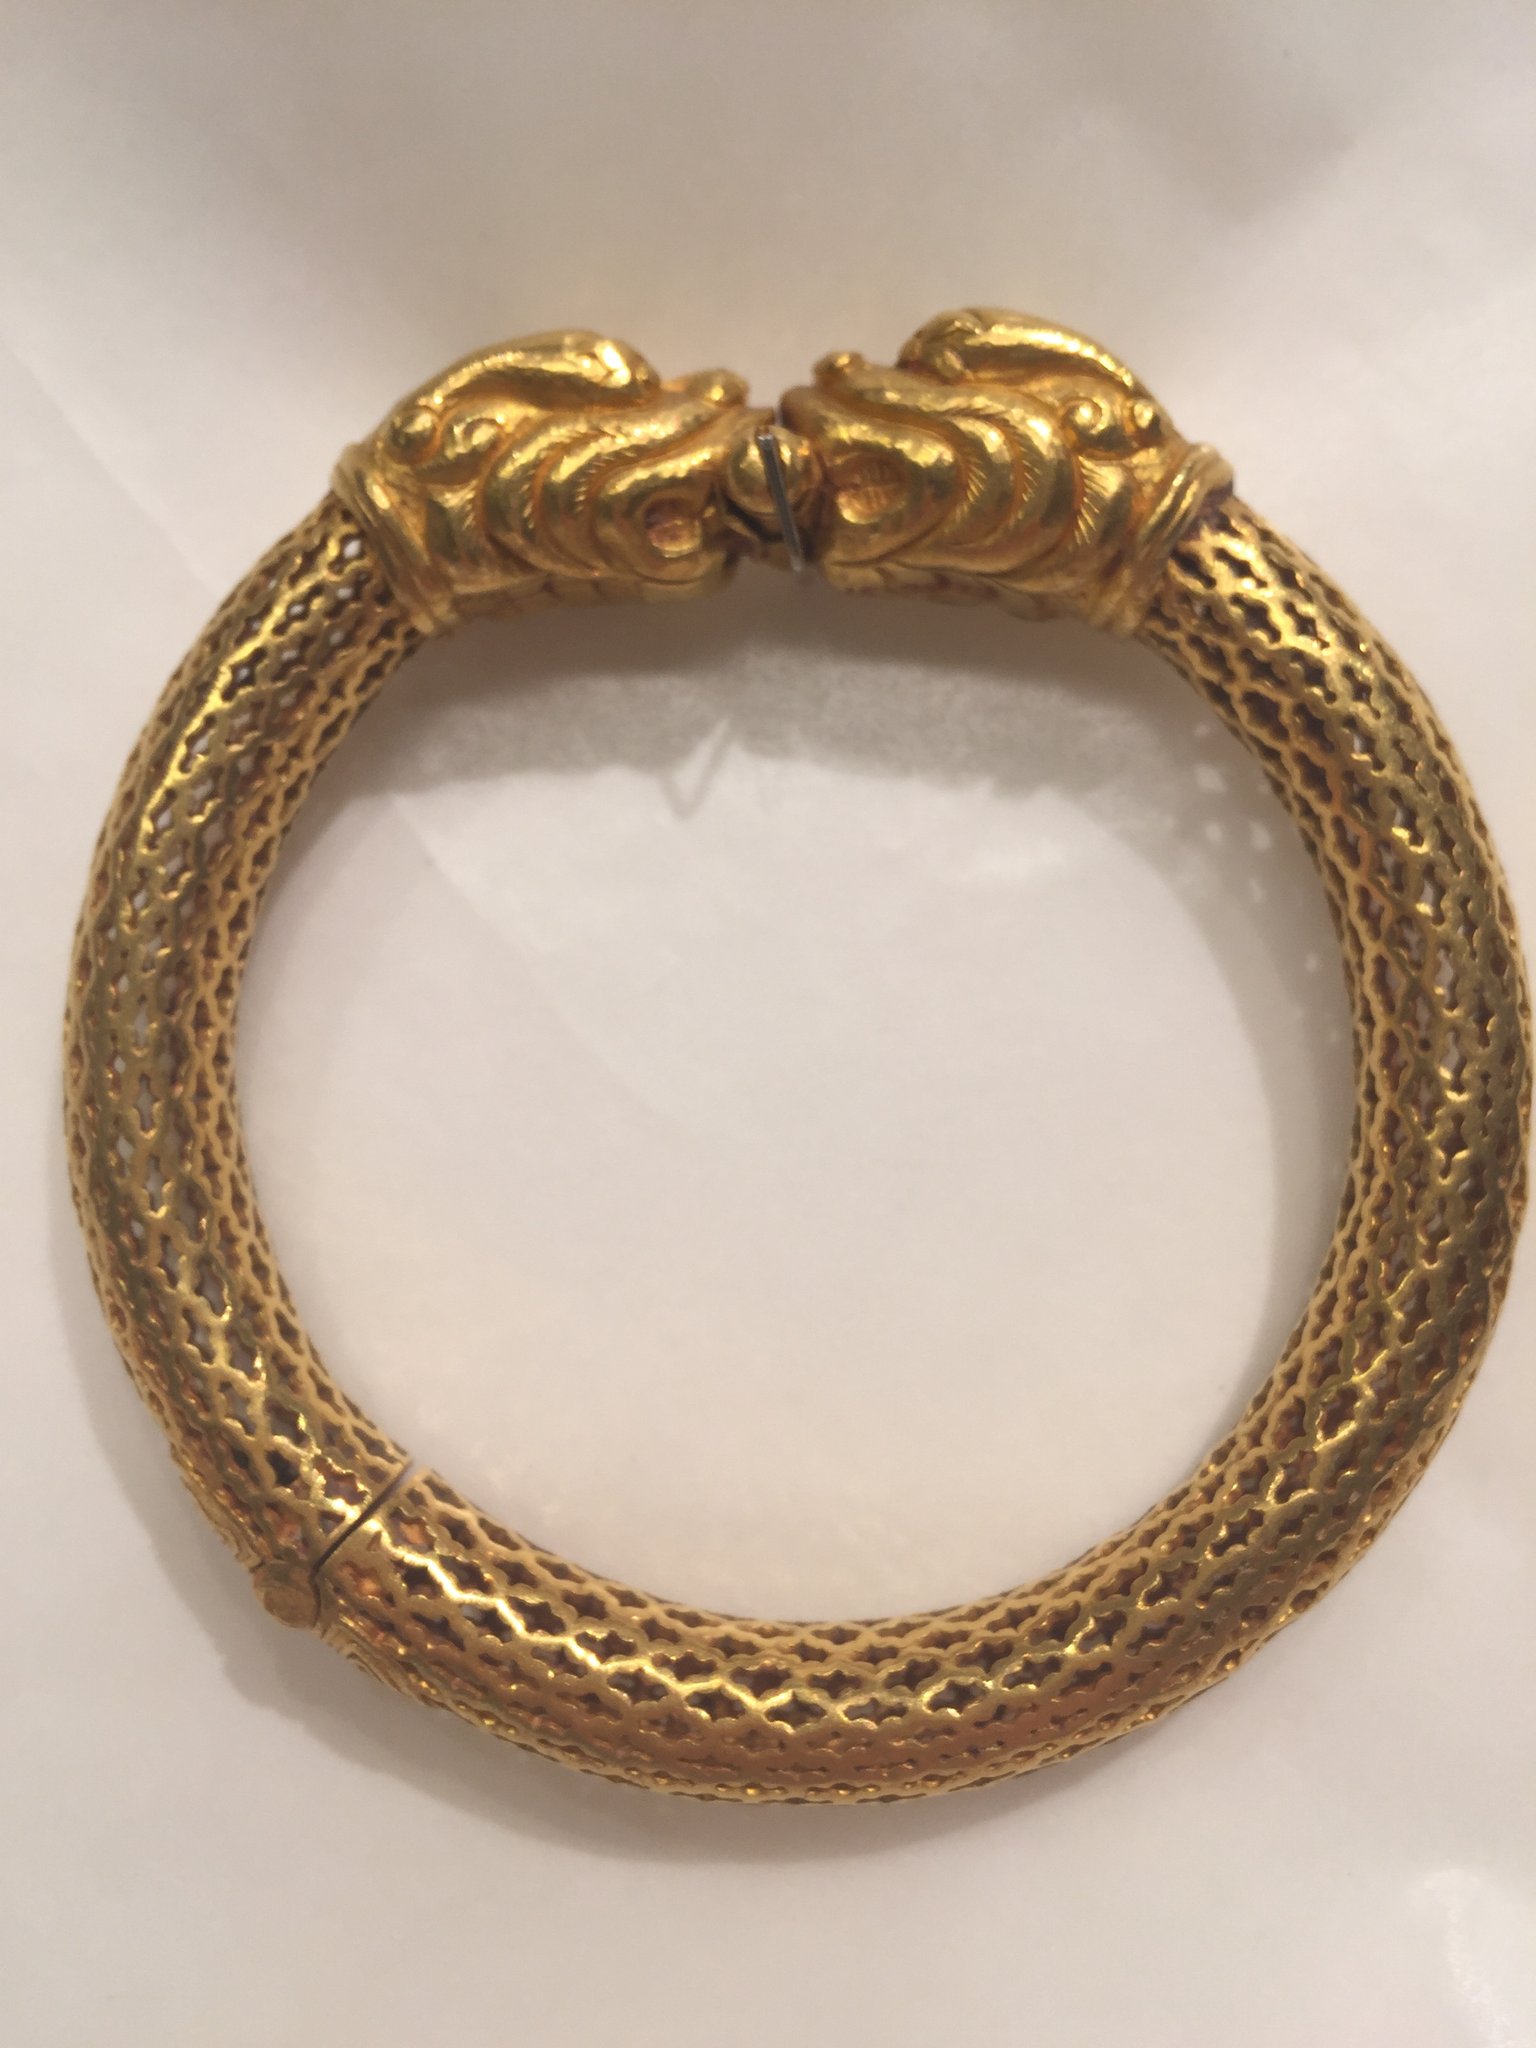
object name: bracelet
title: Bracelet (Kada), One of a Pair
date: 1801-1900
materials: gold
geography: india